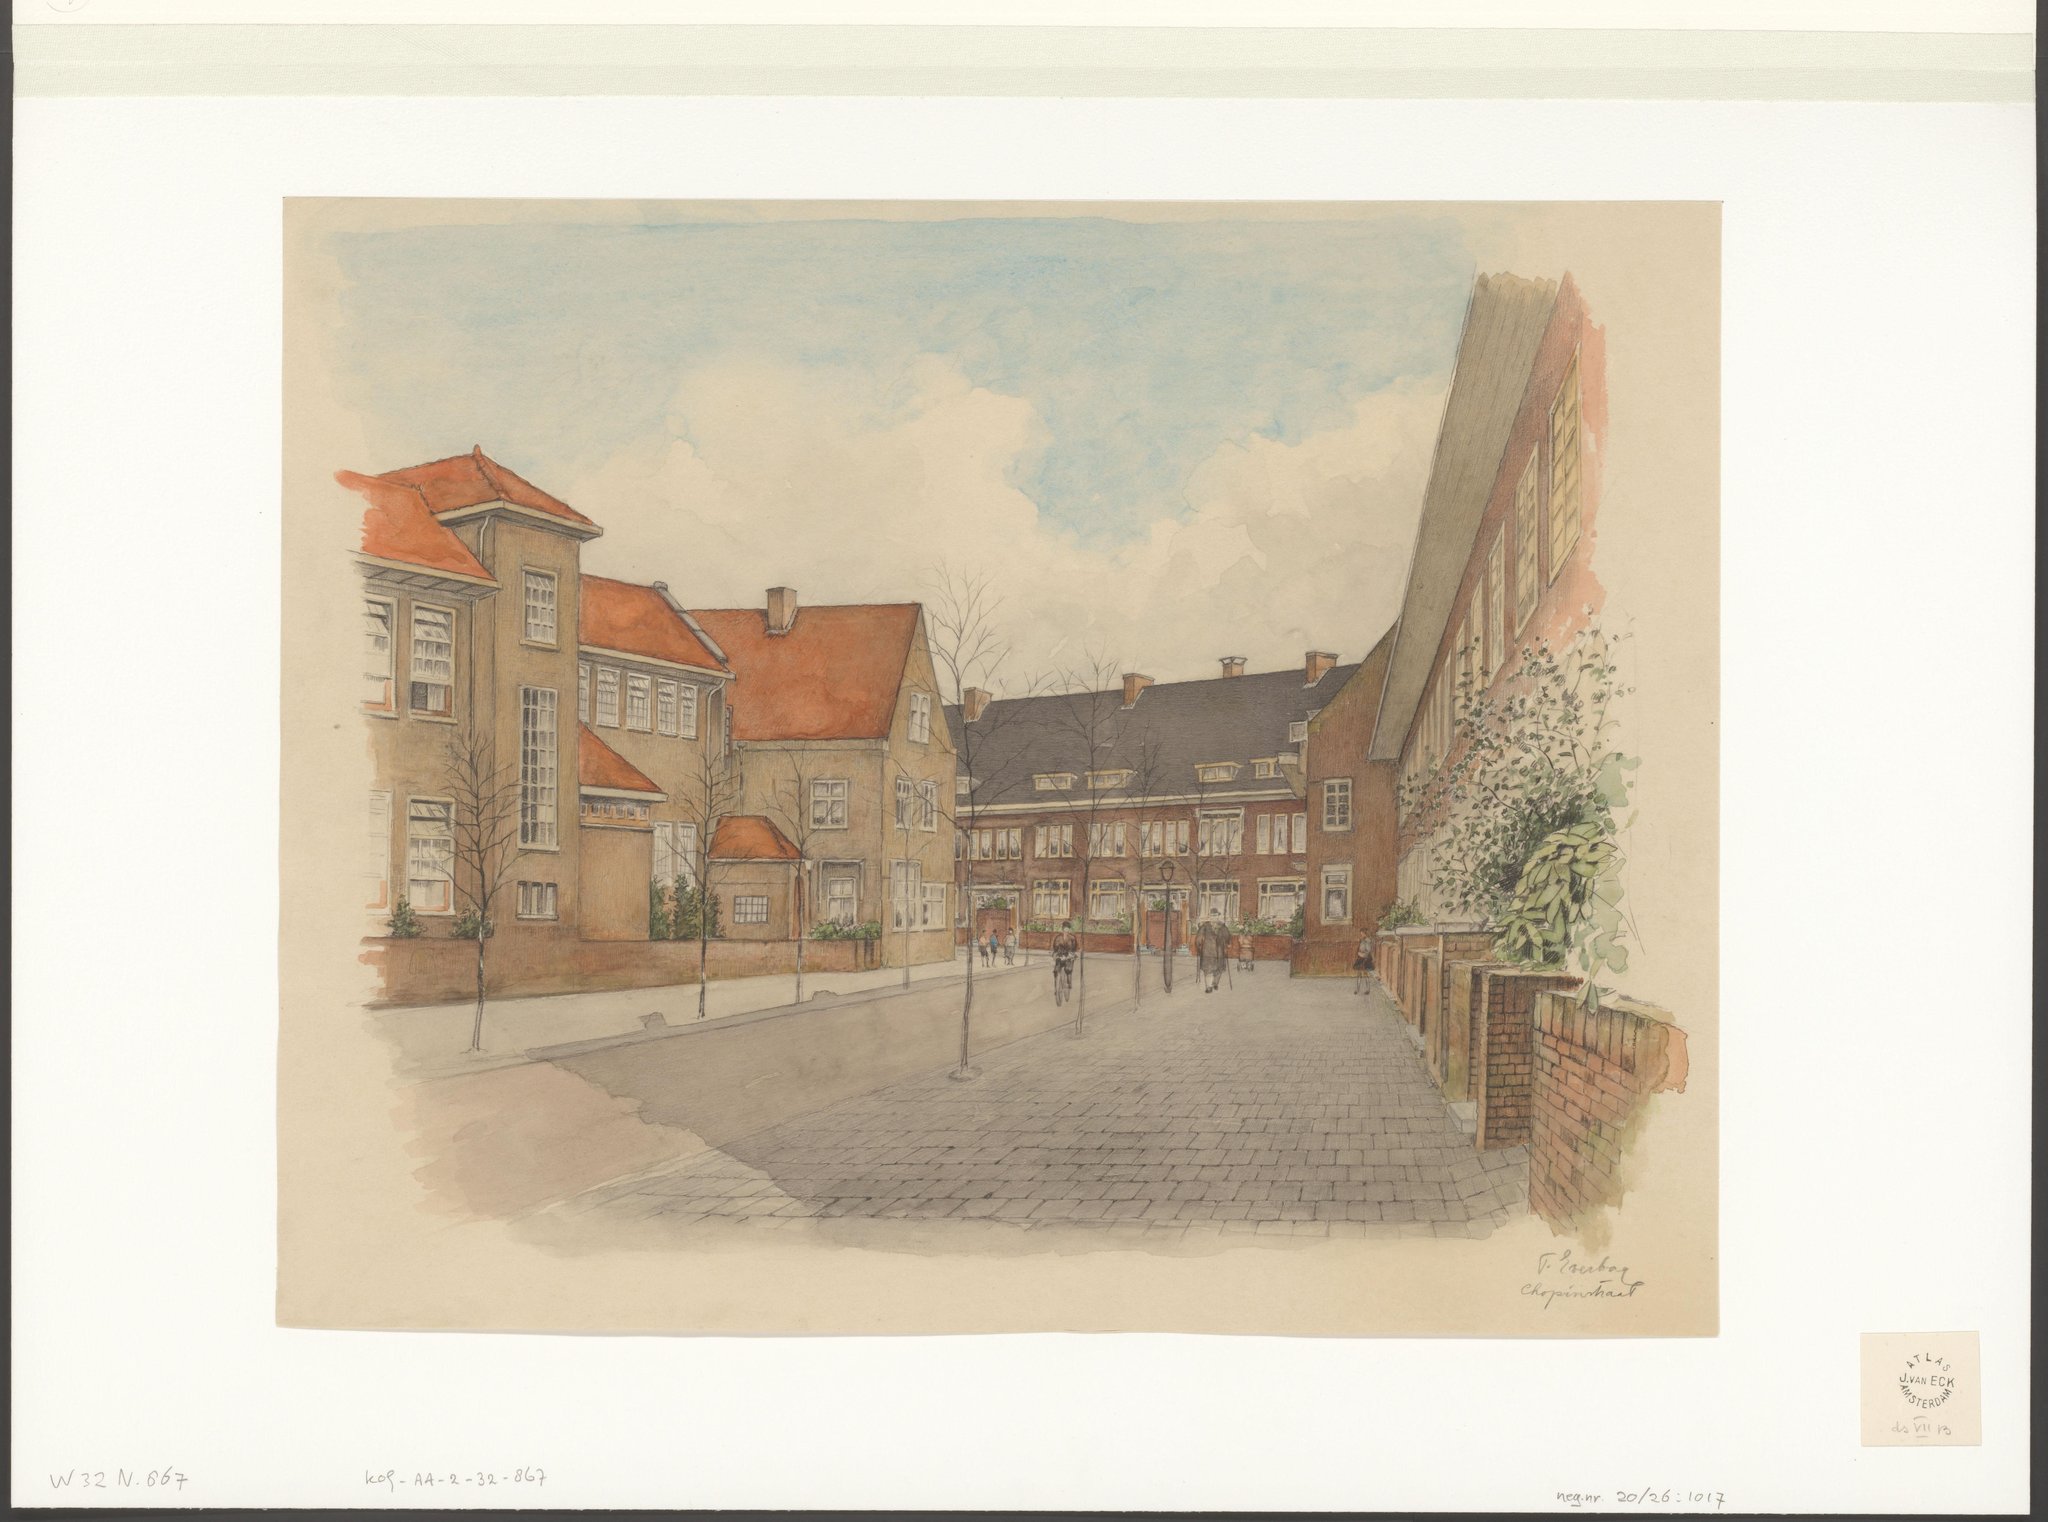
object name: drawing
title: Gezicht op de Chopinstraat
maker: frans everbag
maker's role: draughtsman, print maker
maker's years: 1877-1947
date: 1927-1947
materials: chalk, gouache, paper, pencil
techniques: brush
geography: amsterdam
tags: city-view in general; 'veduta', the usual house or row of houses, street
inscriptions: inscription: ‘Chopinstraat’, collector's mark: Lugt 800a, inscription: ‘Chopinstraat’, signature: ‘F. Everbag’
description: Tekening binnen de Atlas Van Eck ingedeeld op wijknummer 32.